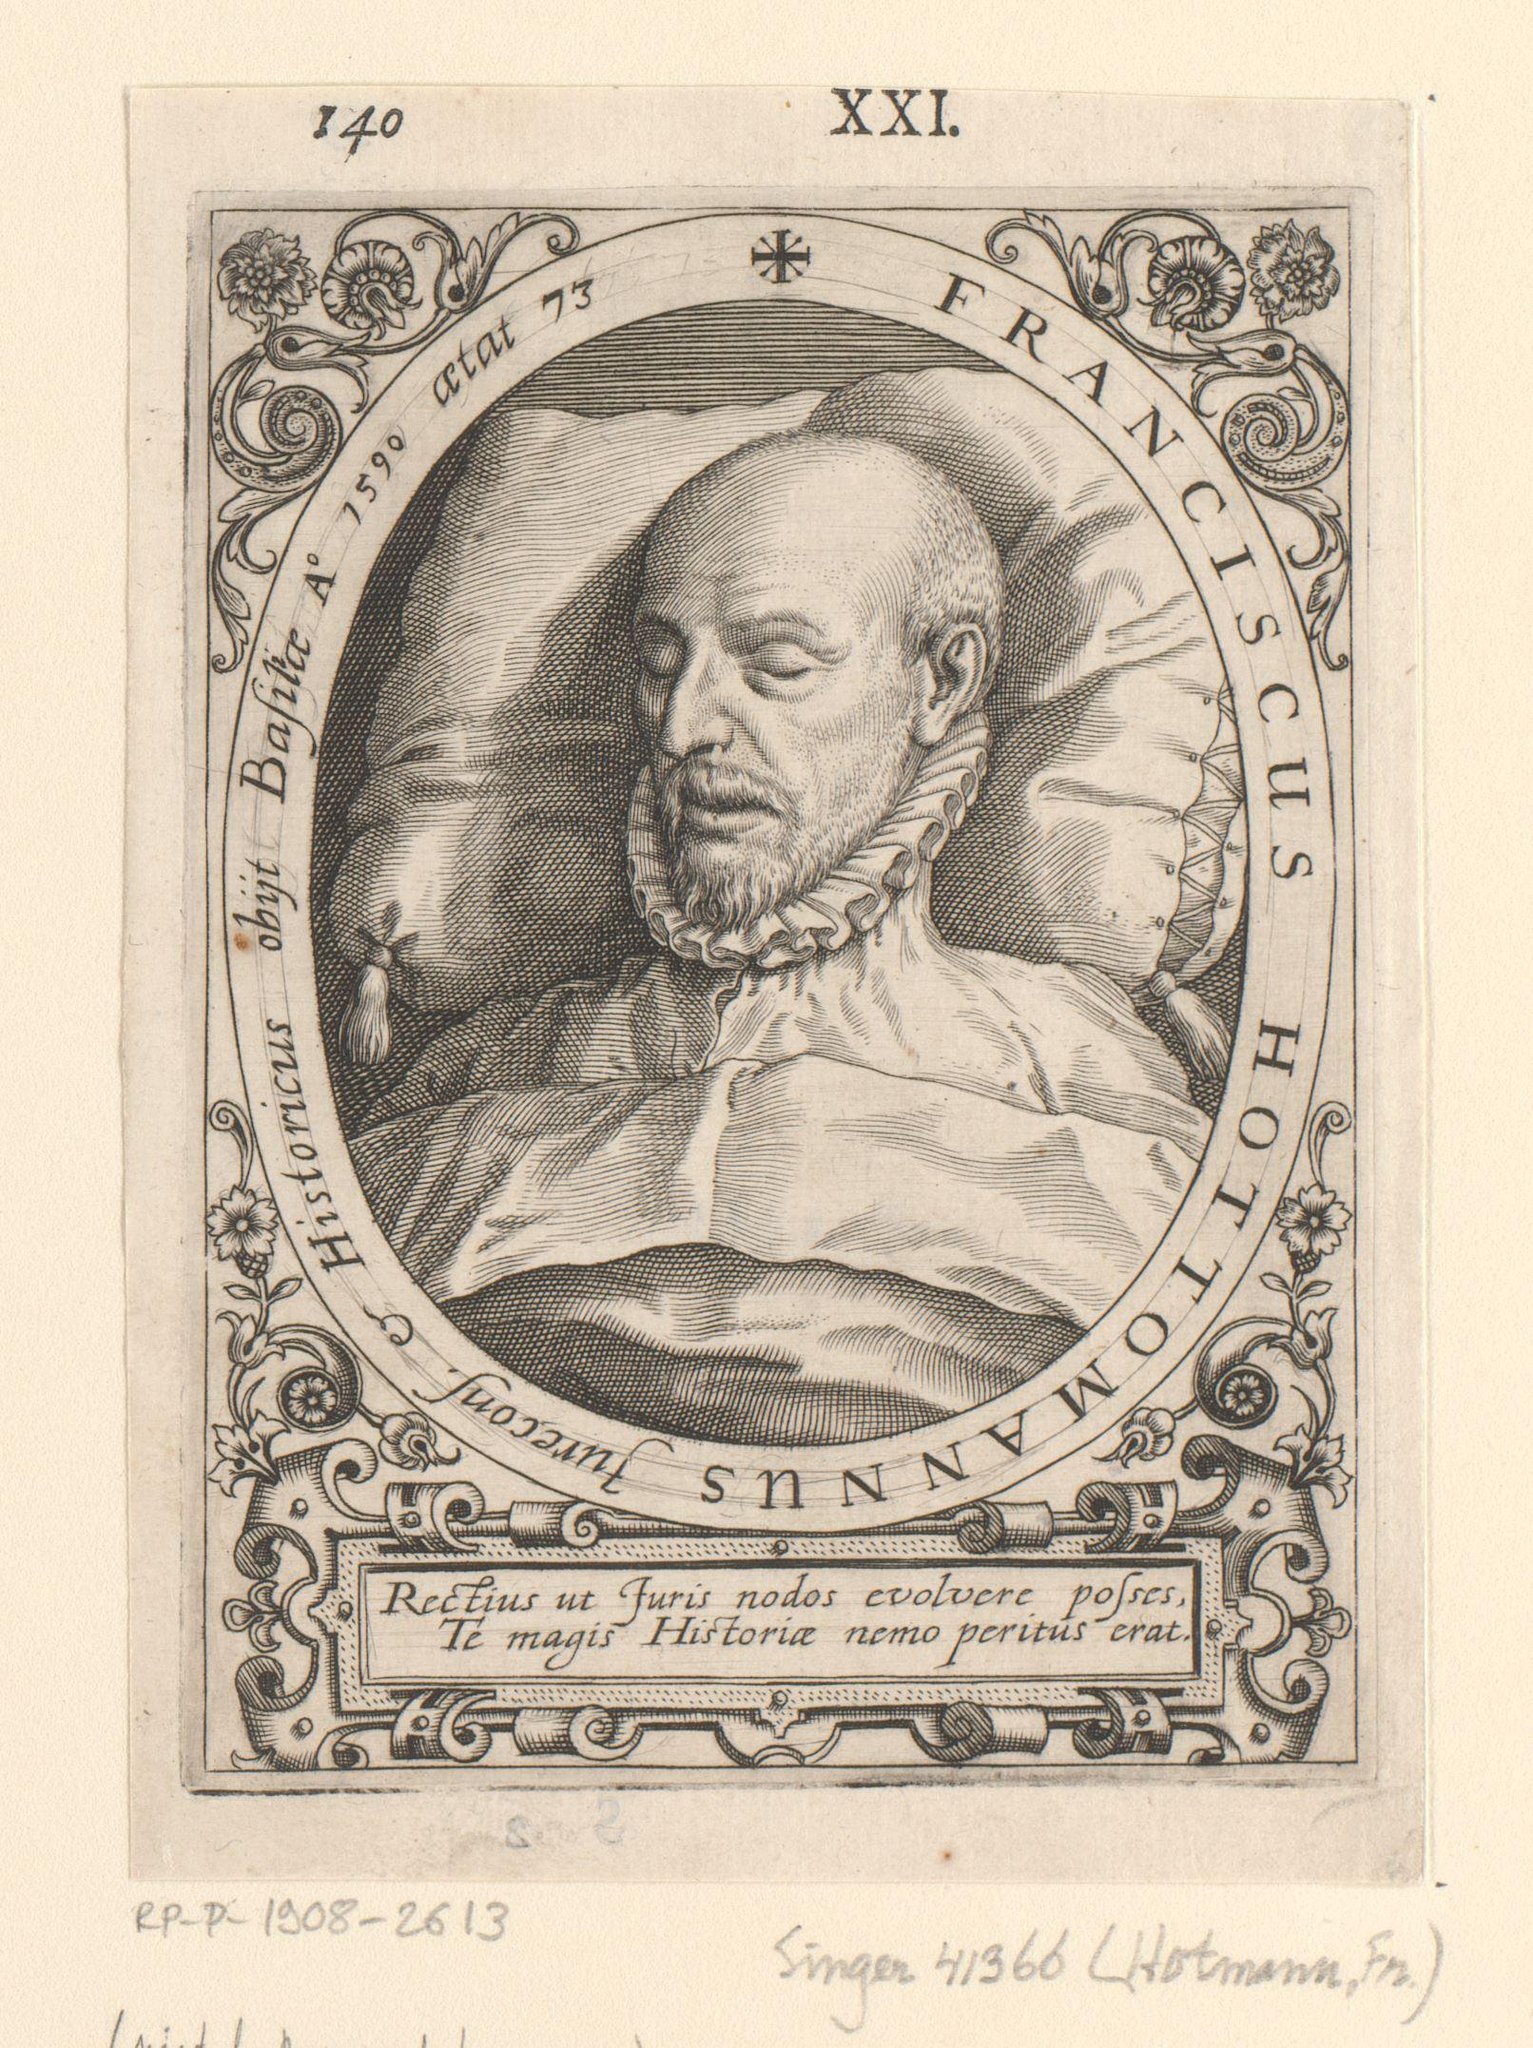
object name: print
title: Portret van François Hotman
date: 1590-1599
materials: paper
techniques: engraving, letterpress printing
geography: frankfurt am main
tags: rechtsgeleerde, françois hotman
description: Gemaakt voor: J.J. Boissard, Icones virorum illustrium doctrina &c eruditione praestanti um contines. Frankfurt am Main: de Bry, 1597-1599.